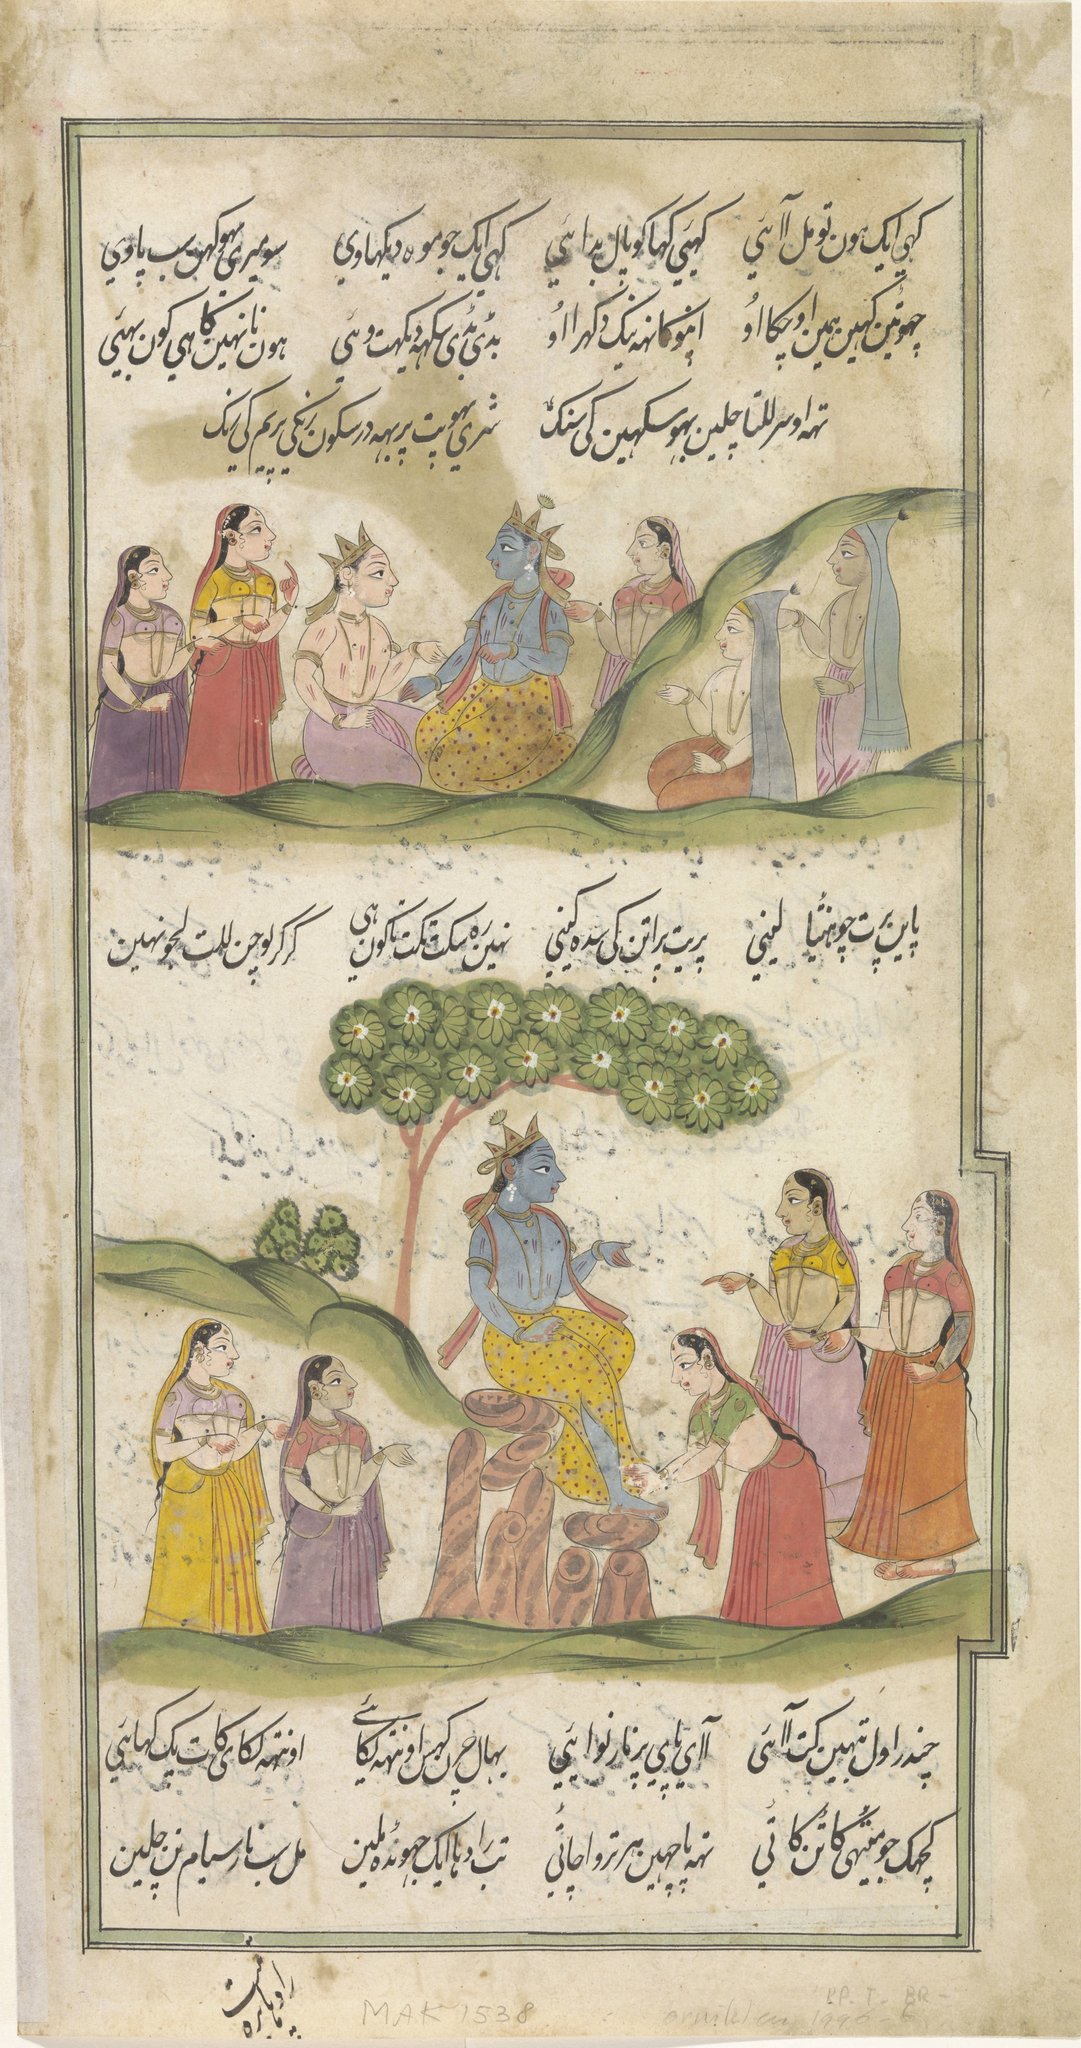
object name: indian miniature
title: Krishna en de herderinnen, tussen tekst in Nastaliq-schrift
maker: Anonymous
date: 1700-1799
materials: paper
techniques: brush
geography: india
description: Op een langwerpig blad staat tussen teksten in Nastaliq-schrift een voorstelling van Krishna met herderinnen voor een grot waarin een man en een vrouw met uitgestrekte hand hem opwachten. Het blad is voorzien van een bies in lichtgroen met zwarte kaderlijnen, de rechterrand vertoont sporen van ergens uitgescheurd te zijn; bovn de kaderlijn aan de bovenrand nog een opschrift.